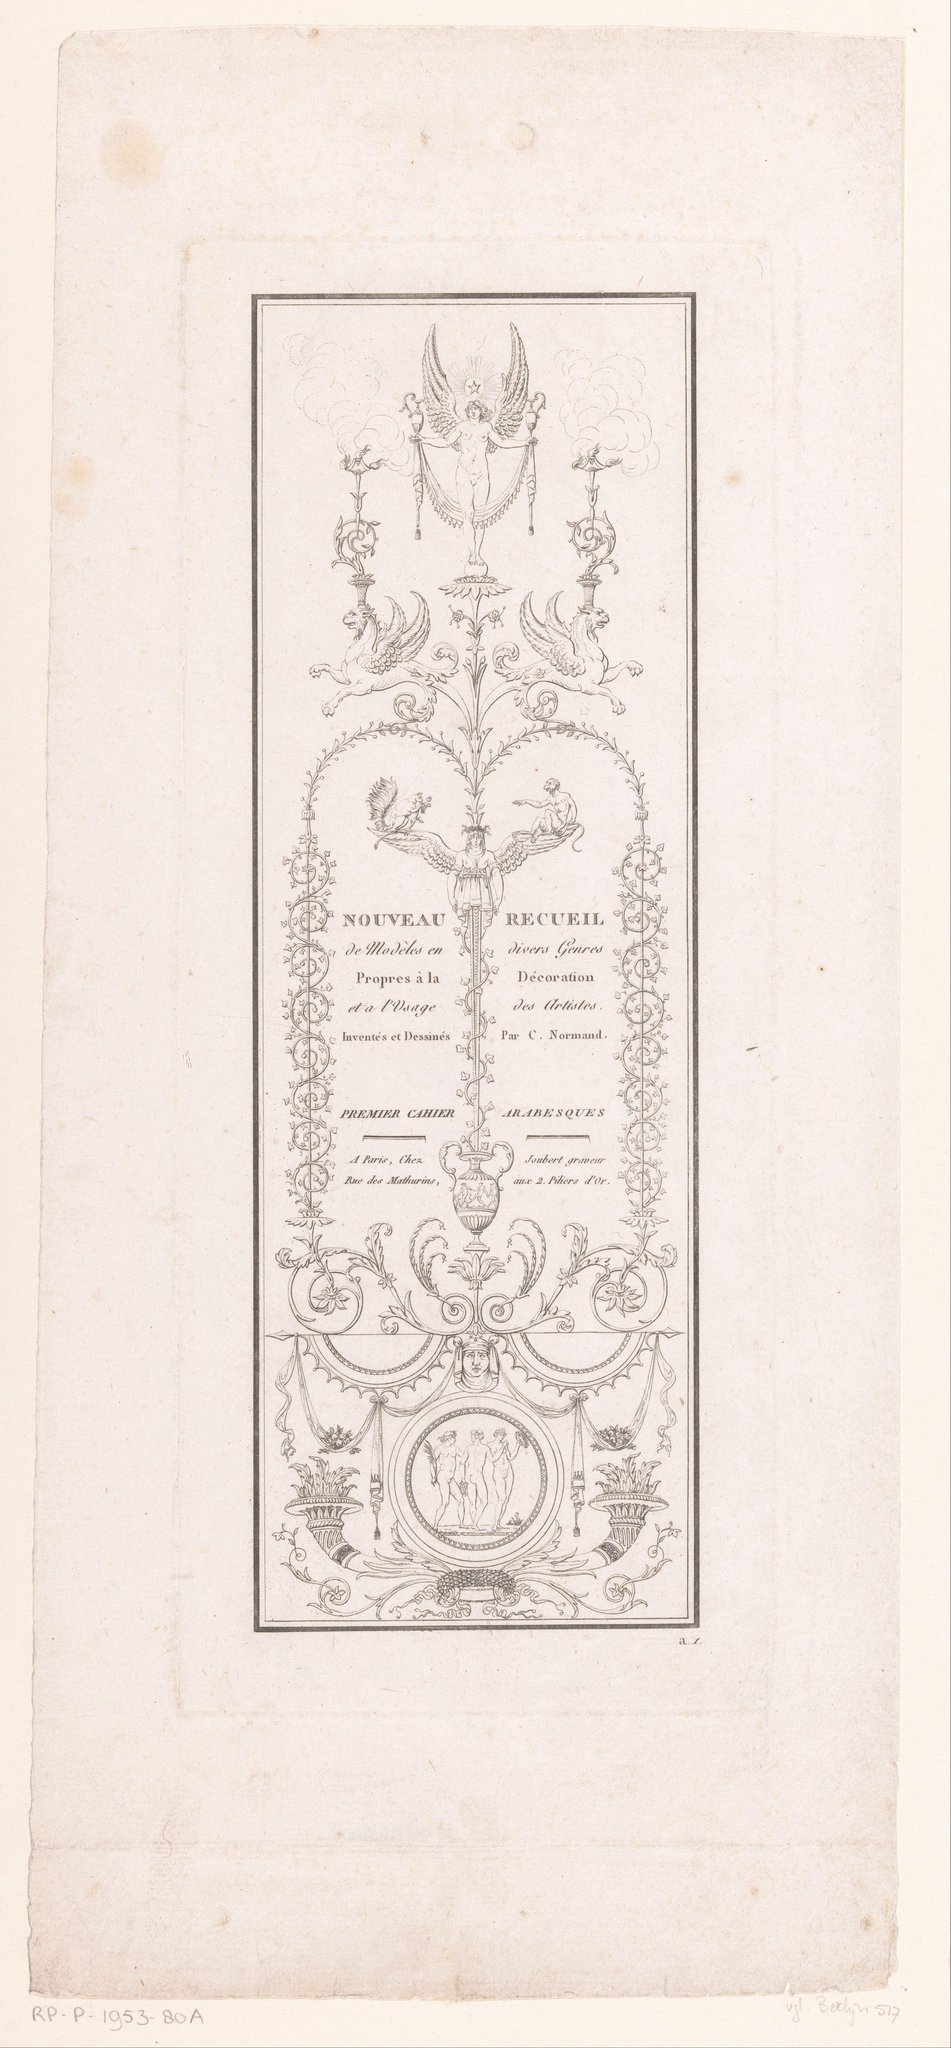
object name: titelprent, frontispice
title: Arabesken met engelen en griffioenen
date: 1803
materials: paper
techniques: engraving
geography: paris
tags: griffin (lion/eagle); 'griffo' (ripa), ornament ~ arabesque, angels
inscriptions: collector's mark: Lugt 2228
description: Verticaal paneel met arabesken met aan de bovenzijde een engel geflankeerd door twee griffioenen en rookvaten. Daaronder de serietitel en in het midden een engel met een eekhoorn en een aap op de vleugels. Aan de onderzijde een rond medaillon met drie naakten en twee hoornen des overvloeds.